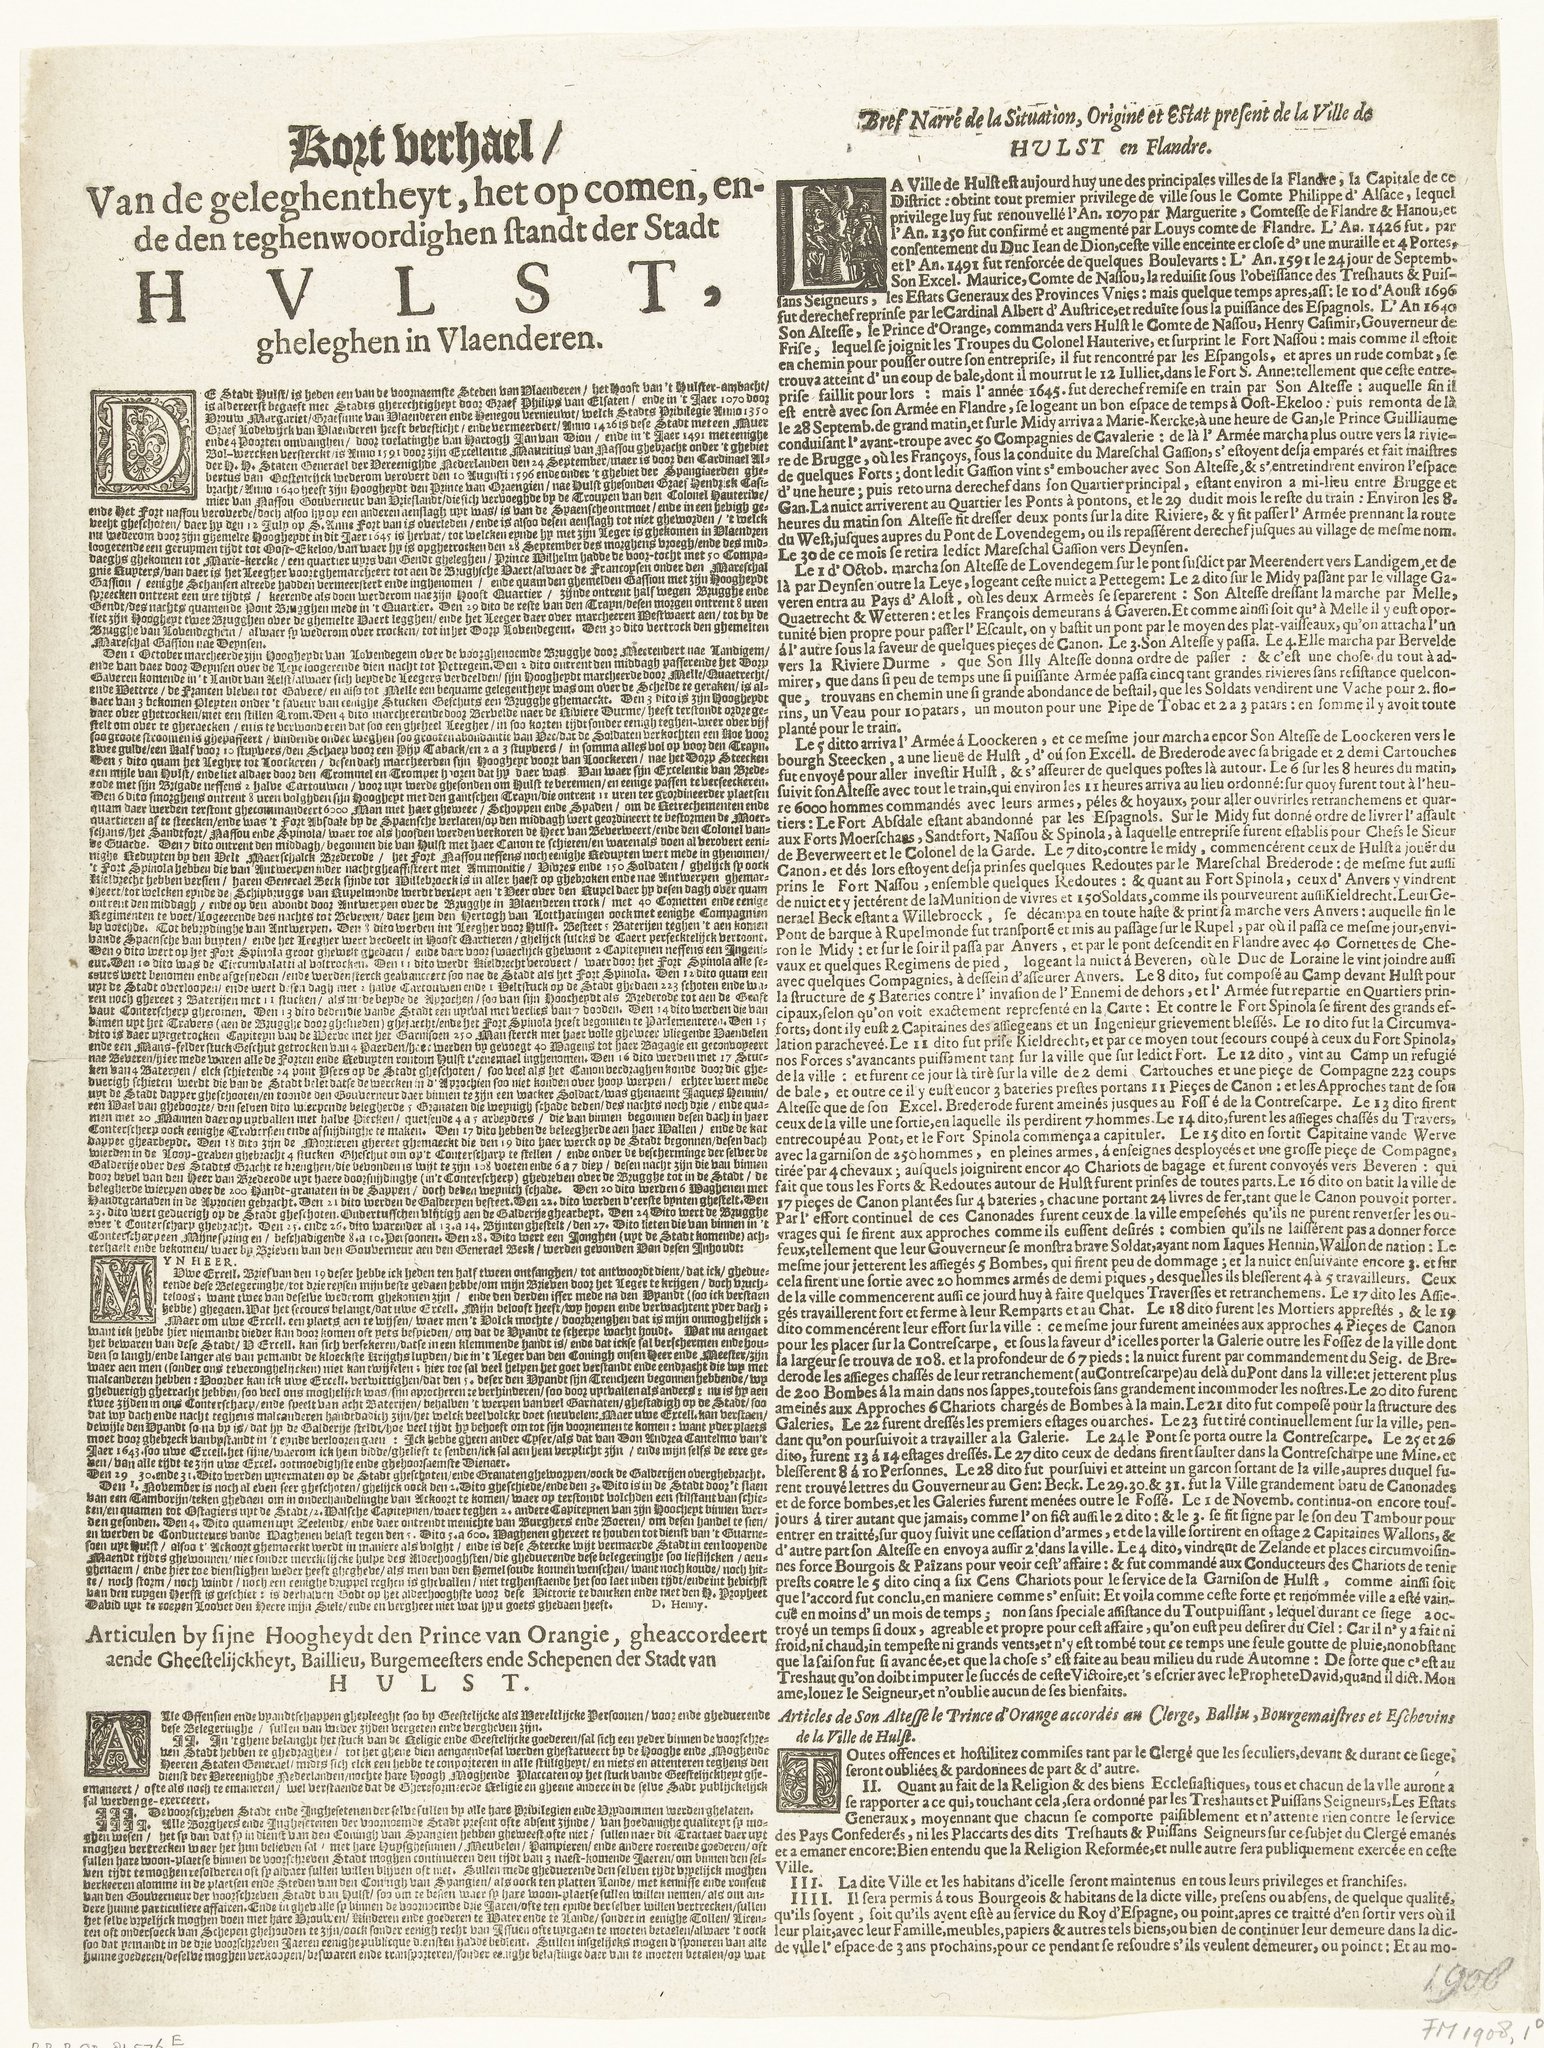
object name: text sheet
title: Tekstblad bij het ensemble van het beleg van Hulst, 1645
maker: claes jansz. visscher (ii)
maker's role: draughtsman, print maker, publisher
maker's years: 1586-1652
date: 1645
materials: paper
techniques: letterpress printing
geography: amsterdam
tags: delft, the hague, frederick henry (prince of orange)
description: Tekstblad bij het ensemble van het beleg van Hulst, belegerd door het Staatse leger onder Frederik Hendrik van 28 september tot 5 november 1645. Blad met twee kolommen tekst in het Nederlands en Frans. Onderaan de artikelen van de overgave van de stad. Wellicht onderdeel van een ongemonteerd ensemble bestaande uit de twee kaarten, het profiel, het blad met de zes forten, de drie bladen van de uittocht van het garnizoen en de twee tekstbladen.